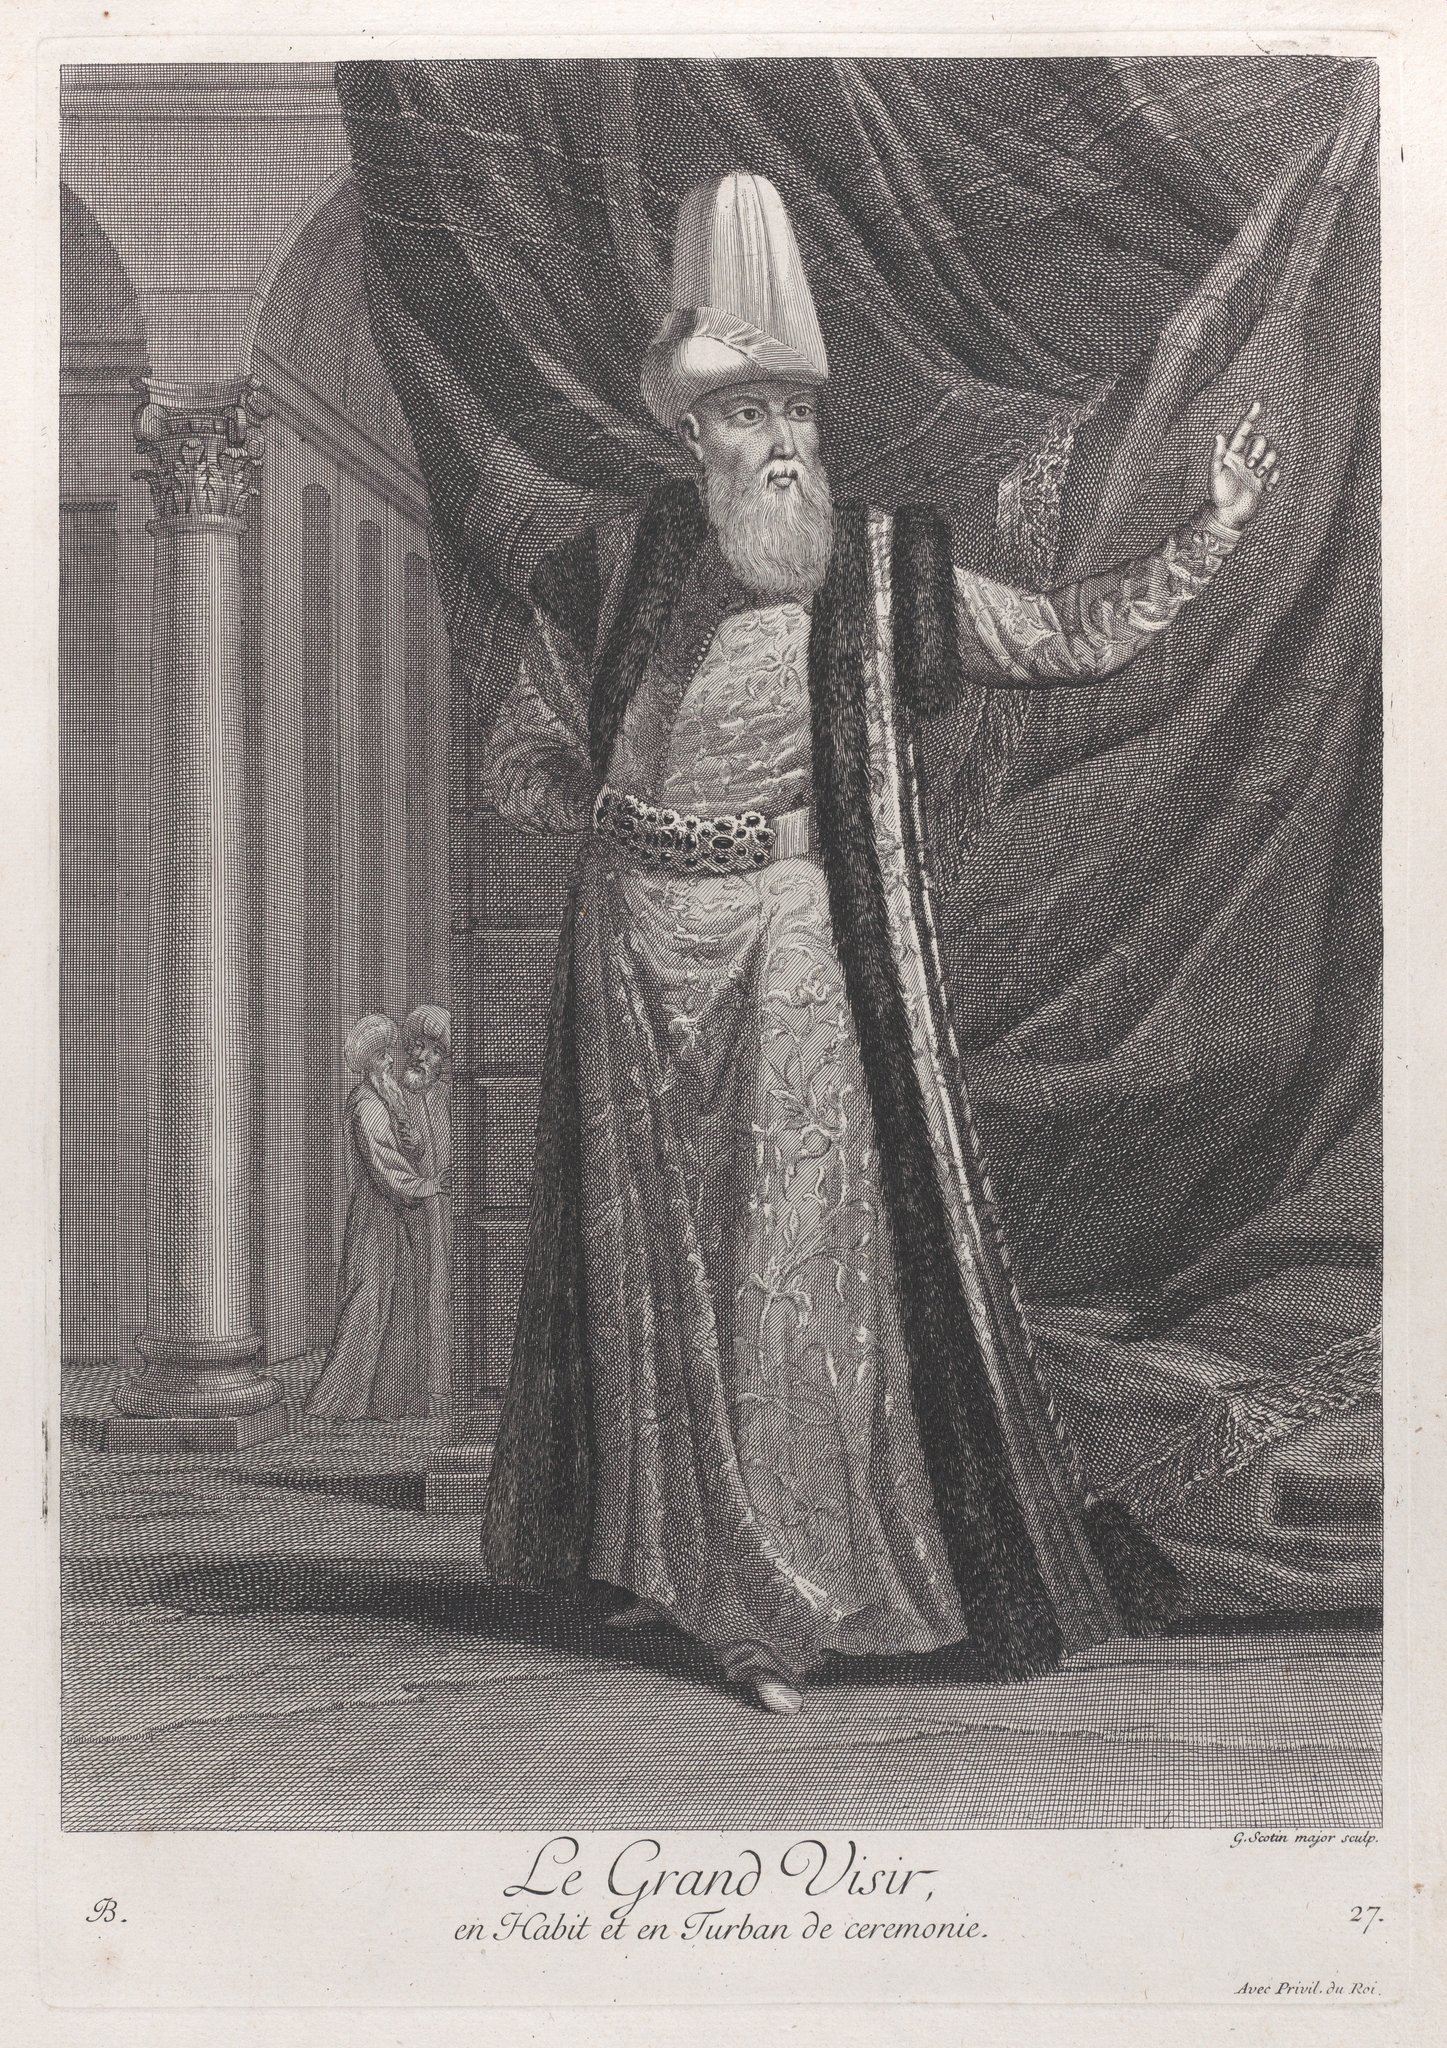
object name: print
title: Le Grand Visir, en Habit et en Turban de ceremonie, plate 27 from "Recueil de cent estampes représentent differentes nations du Levant"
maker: jean baptiste vanmour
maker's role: artist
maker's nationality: french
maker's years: 1671-1737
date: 1714-1715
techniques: engraving, etching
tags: men